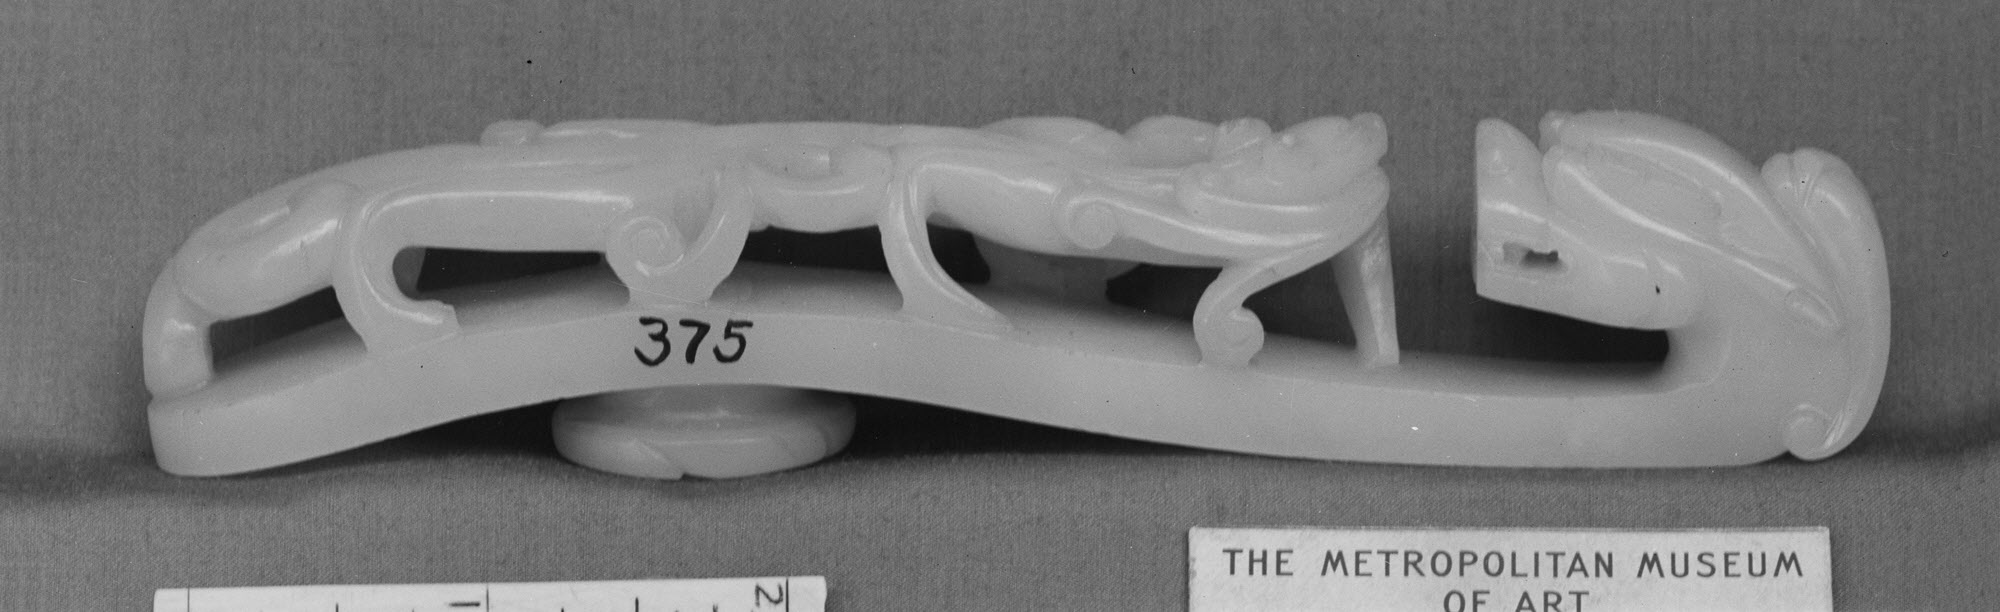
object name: girdle buckle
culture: chinese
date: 1368-1644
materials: jade